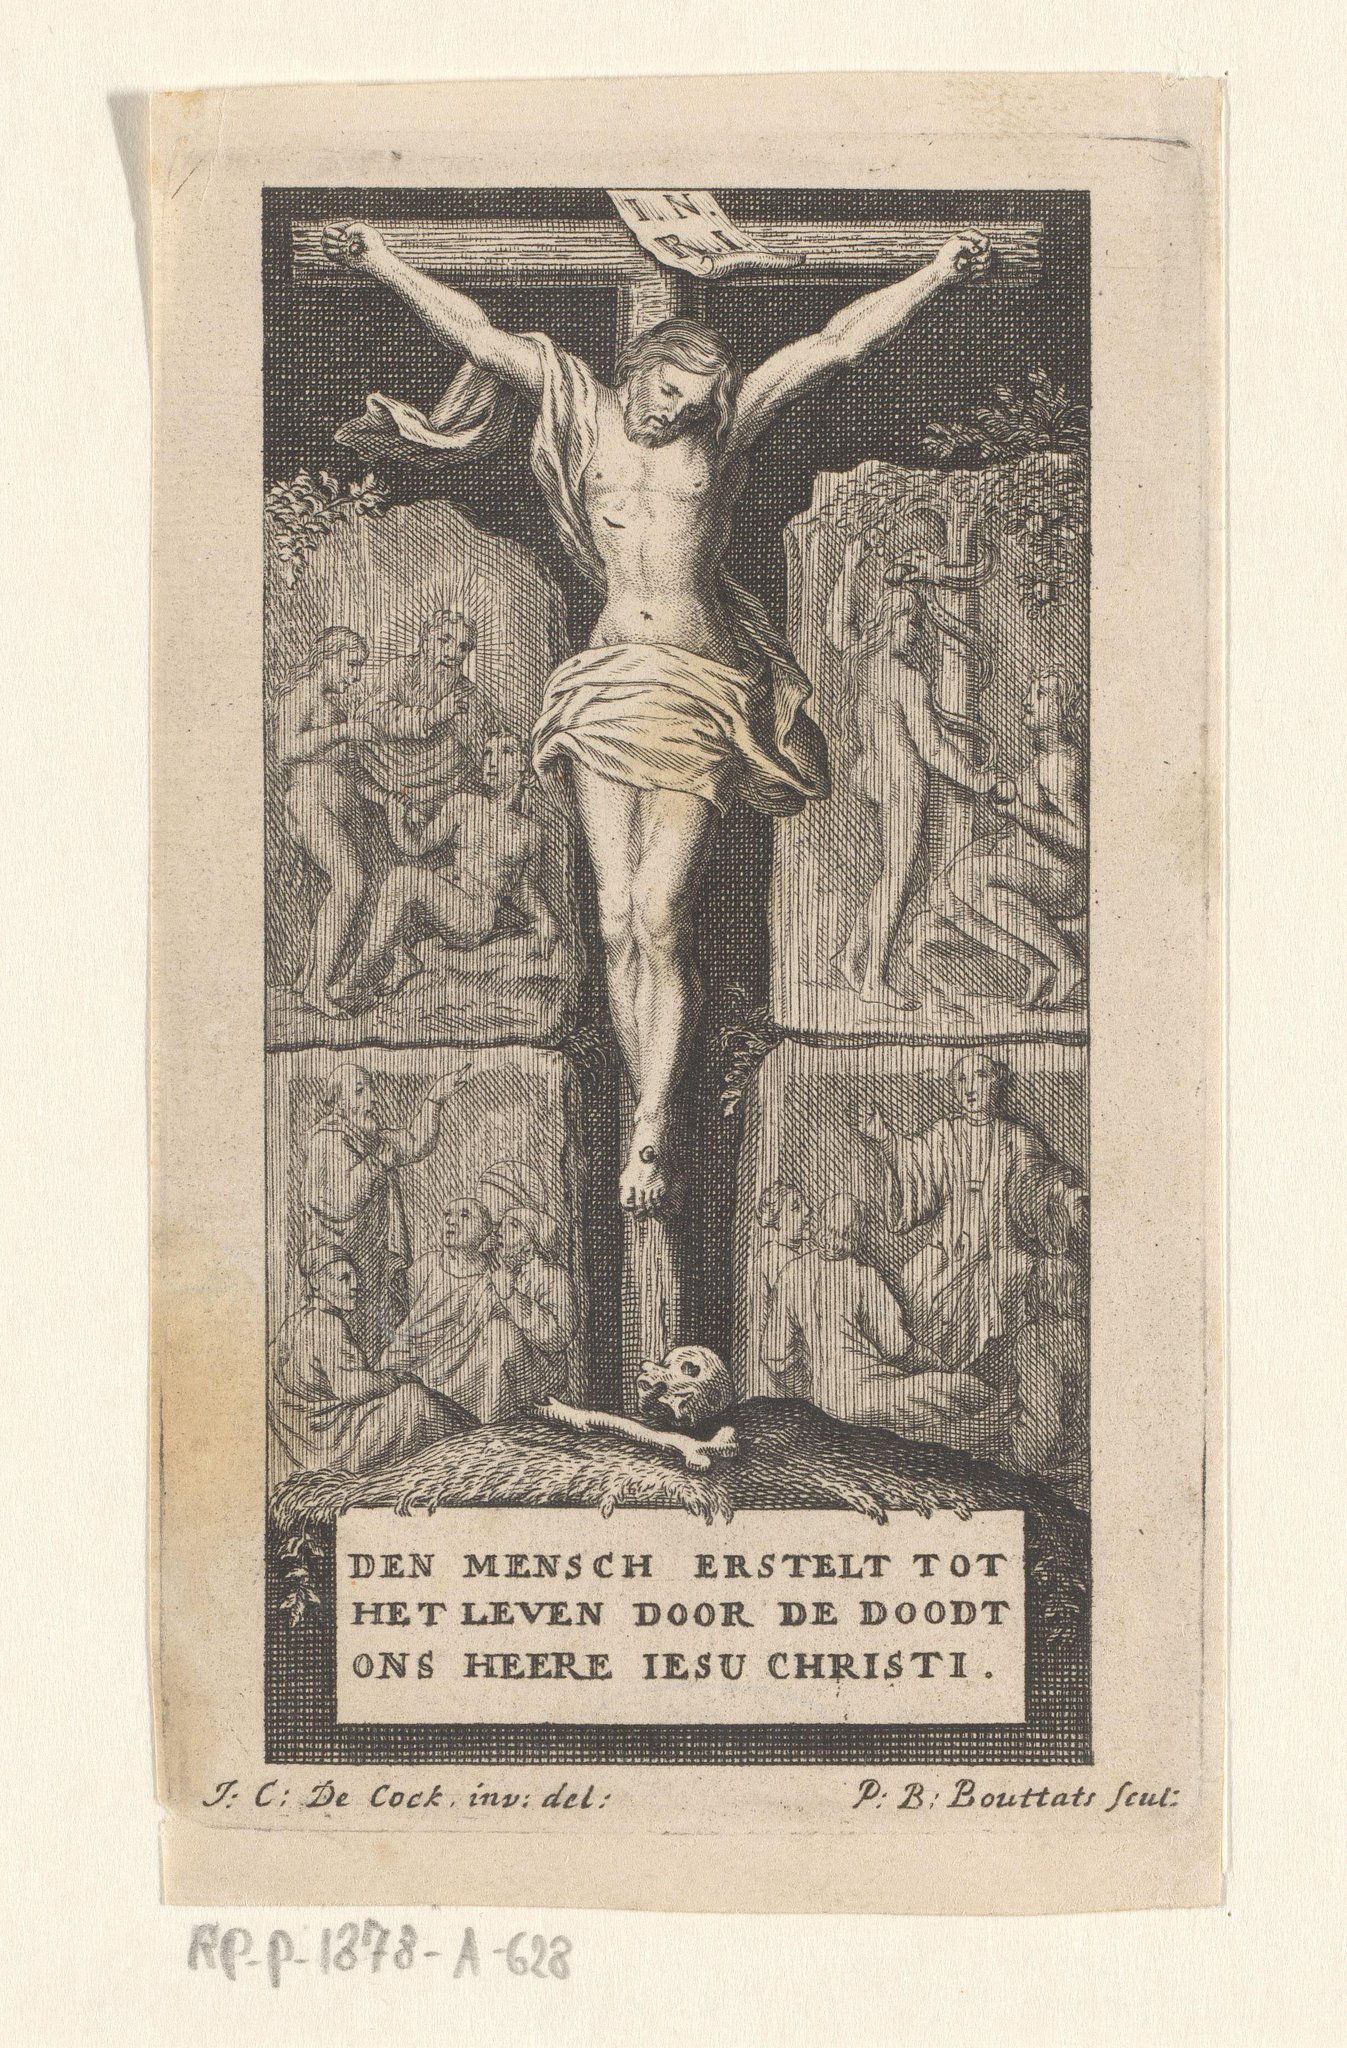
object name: print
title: Christus aan het kruis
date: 1676-1755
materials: paper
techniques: engraving, etching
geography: antwerp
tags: christ preaching or teaching (in general), creation of eve, temptation and fall: adam and eve in paradise (after the fall) (genesis 3:8-21), the crucifixion of christ: christ's death on the cross; golgotha (matthew 27:45-58; mark 15:33-45; luke 23:44-52; john 19:25-38)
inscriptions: collector's mark: Lugt 2228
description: Christus aan een T-vormig kruis. Langs beide kanten van het kruis twee voorstellingen. De twee bovenste verwijzen naar de schepping van de mens en de val van Adam en Eva. De twee onderste naar de leer van Christus. Onder het kruis een cartouche met een Nederlandse tekst:'Den mensch erstelt tot het leven door de doodt ons heere Iesu Christi'